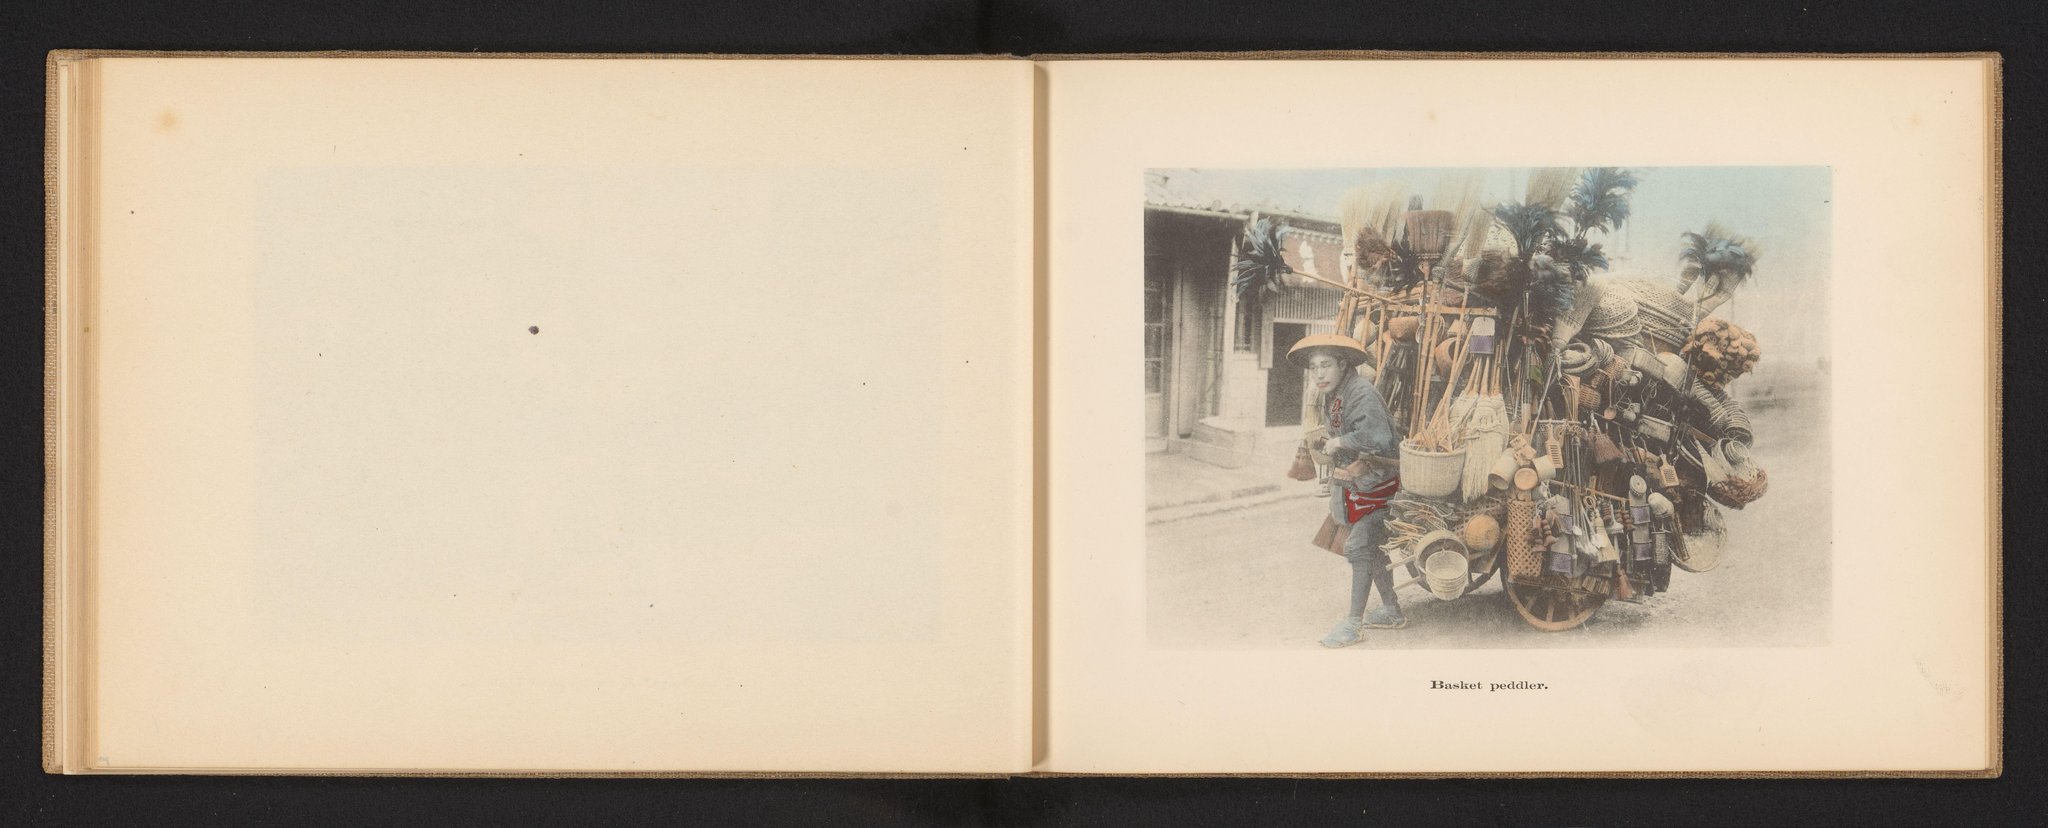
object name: page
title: Basket peddler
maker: kōzaburō tamamura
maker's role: fotograaf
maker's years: 1856-1923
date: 1895-1905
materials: paper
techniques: photograph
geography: japan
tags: wandering or travelling merchant, japan